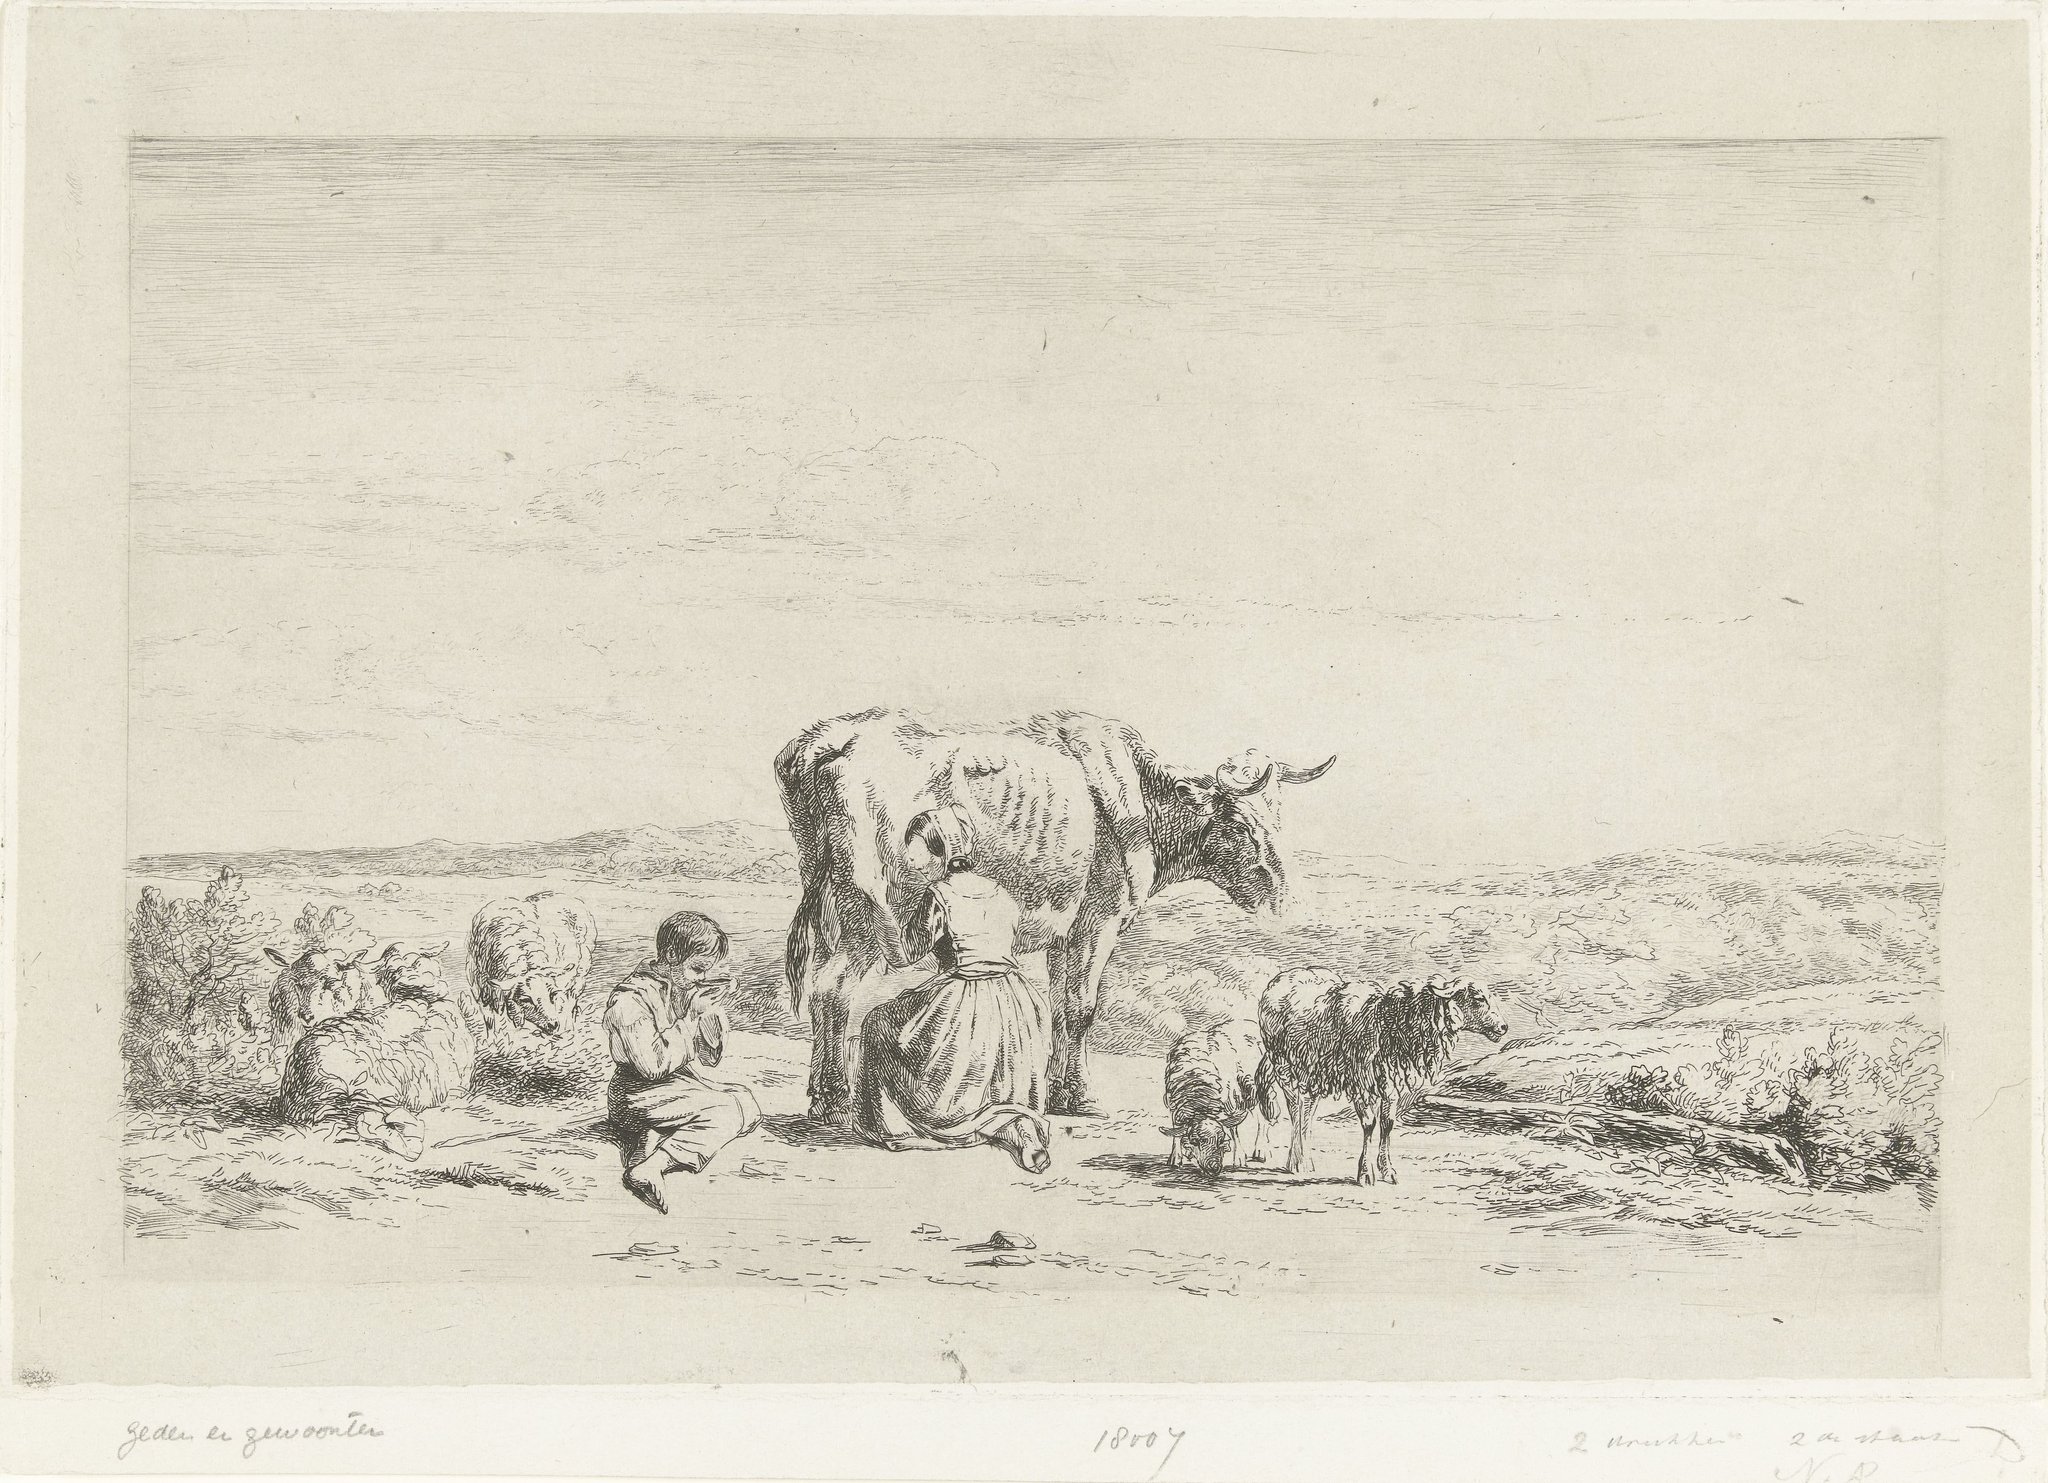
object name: print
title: Landschap met vrouw die koe melkt en jongen met schapen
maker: simon van den berg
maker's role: draughtsman, print maker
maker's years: 1812-1891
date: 1822-1893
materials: paper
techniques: etching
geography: netherlands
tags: cow, sheep, milking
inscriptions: collector's mark: Lugt 2228